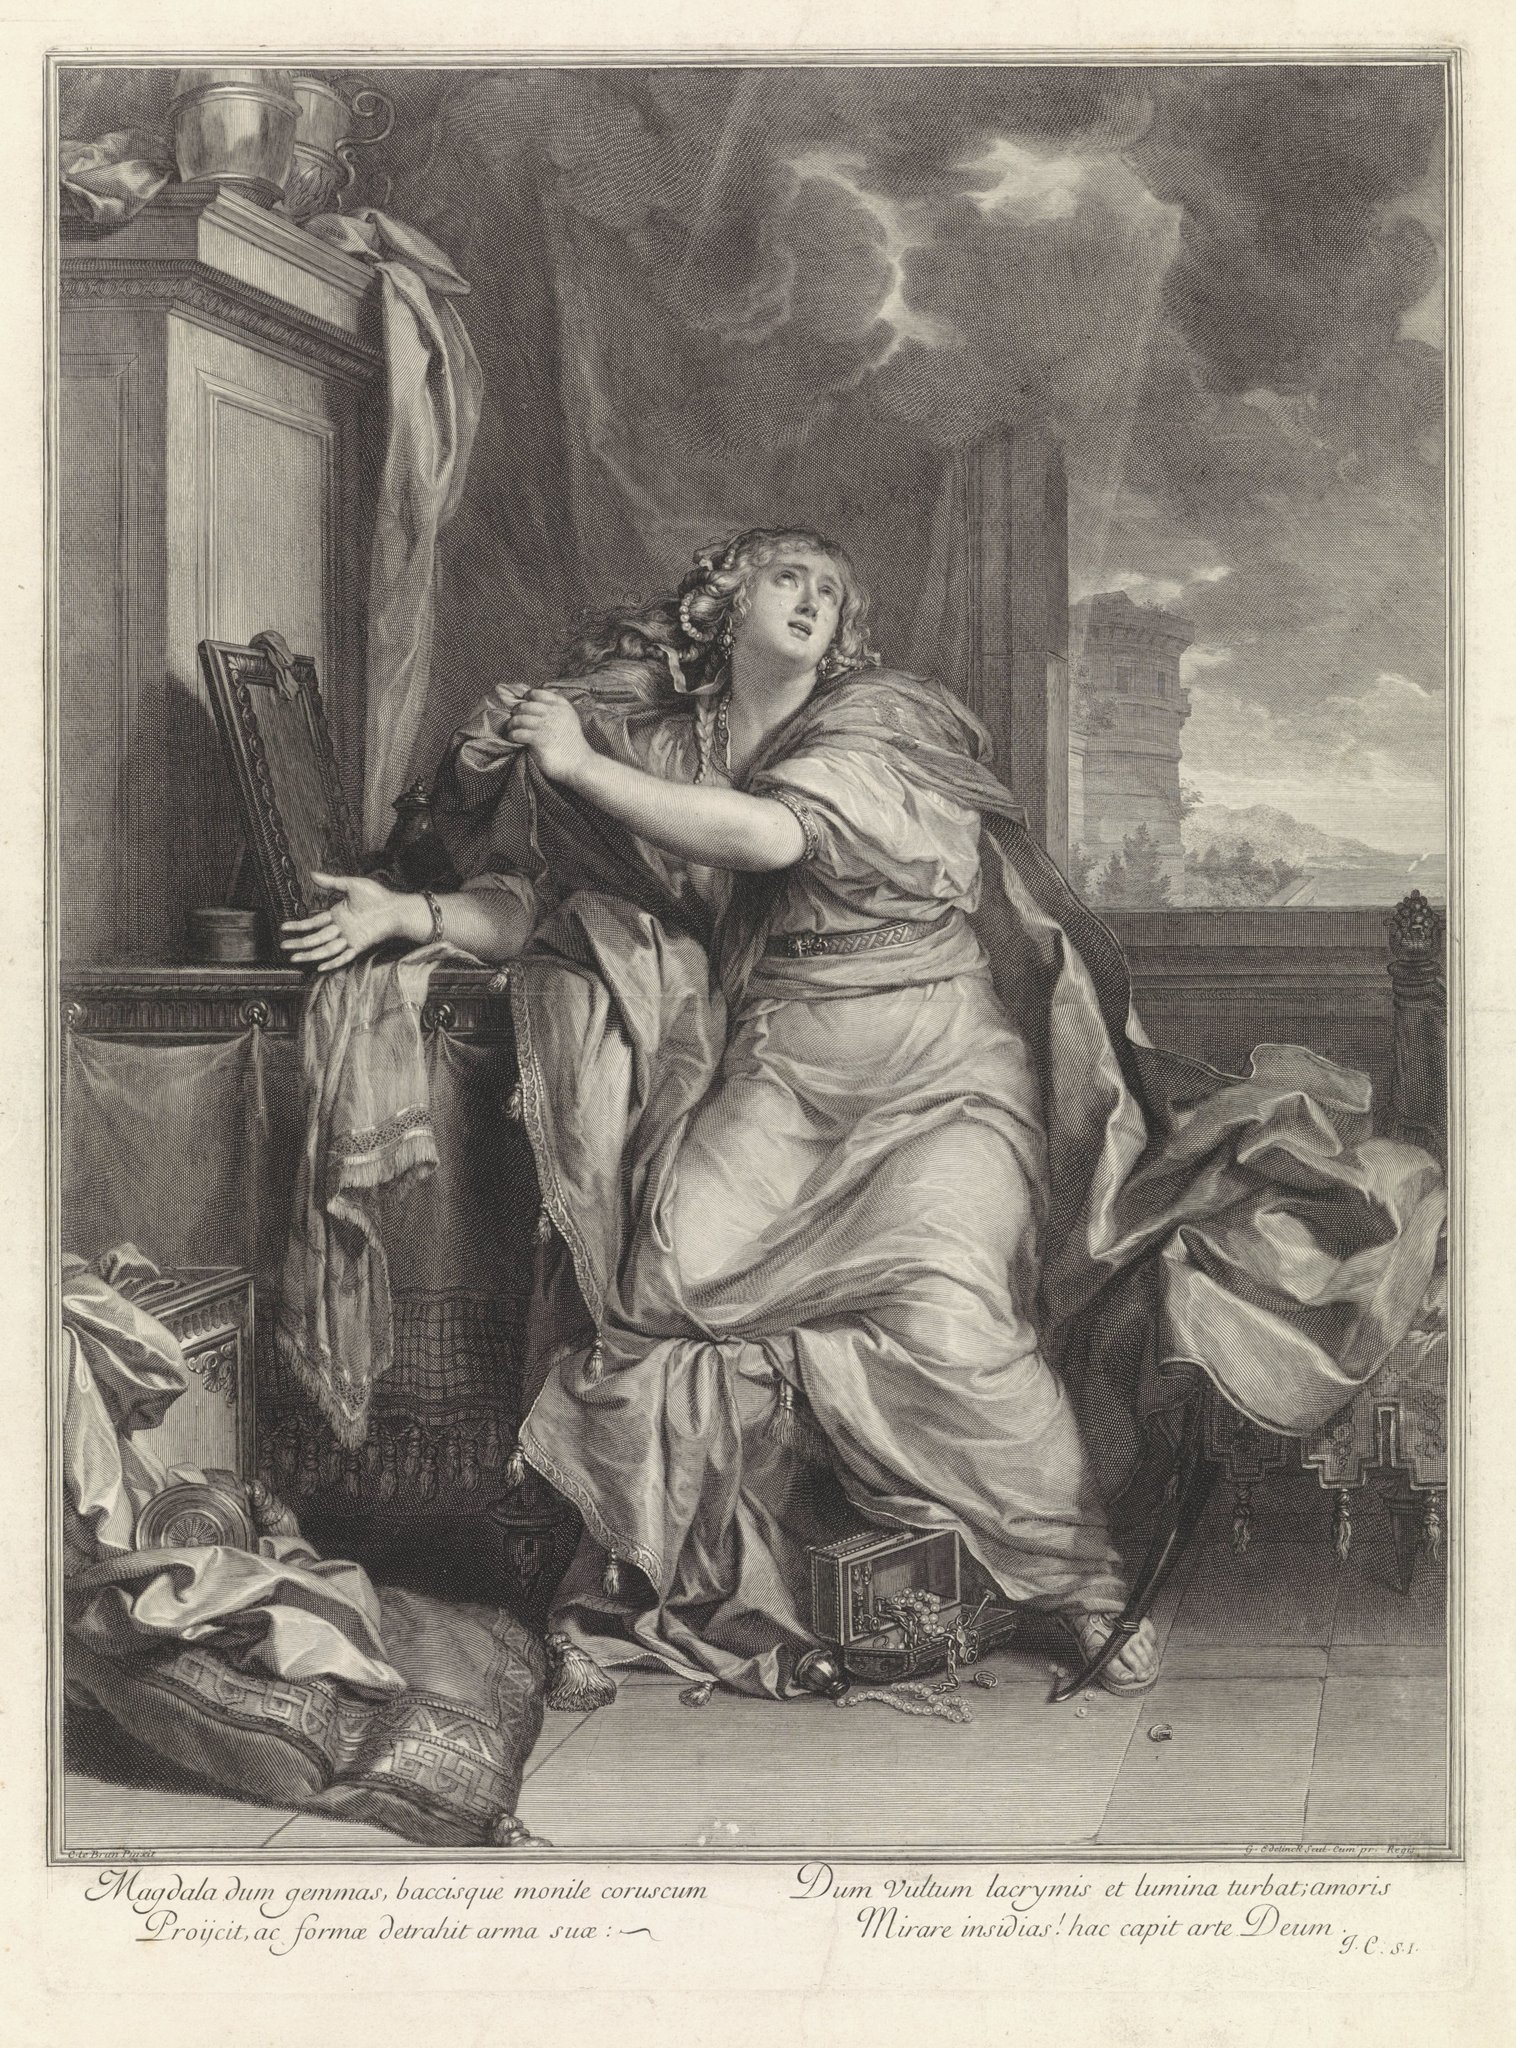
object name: print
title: Maria Magdalena doet afstand van wereldse ijdelheden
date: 1666-1707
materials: paper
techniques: engraving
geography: paris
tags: the penitent harlot mary magdalene; possible attributes: book (or scroll), crown, crown of thorns, crucifix, jar of ointment, mirror, musical instrument, palm-branch, rosary, scourge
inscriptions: collector's mark: Lugt 240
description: Maria Magdalena, zittend aan haar toilet, kijkt met betraande ogen op naar lichtstralen vanuit de hemel. Ze neemt afstand van alle wereldse ijdelheden door haar juwelen en mantel af te werpen. Aan haar voeten ligt een juwelenkistje. Onder de voorstelling vier regels tekst in Latijn.